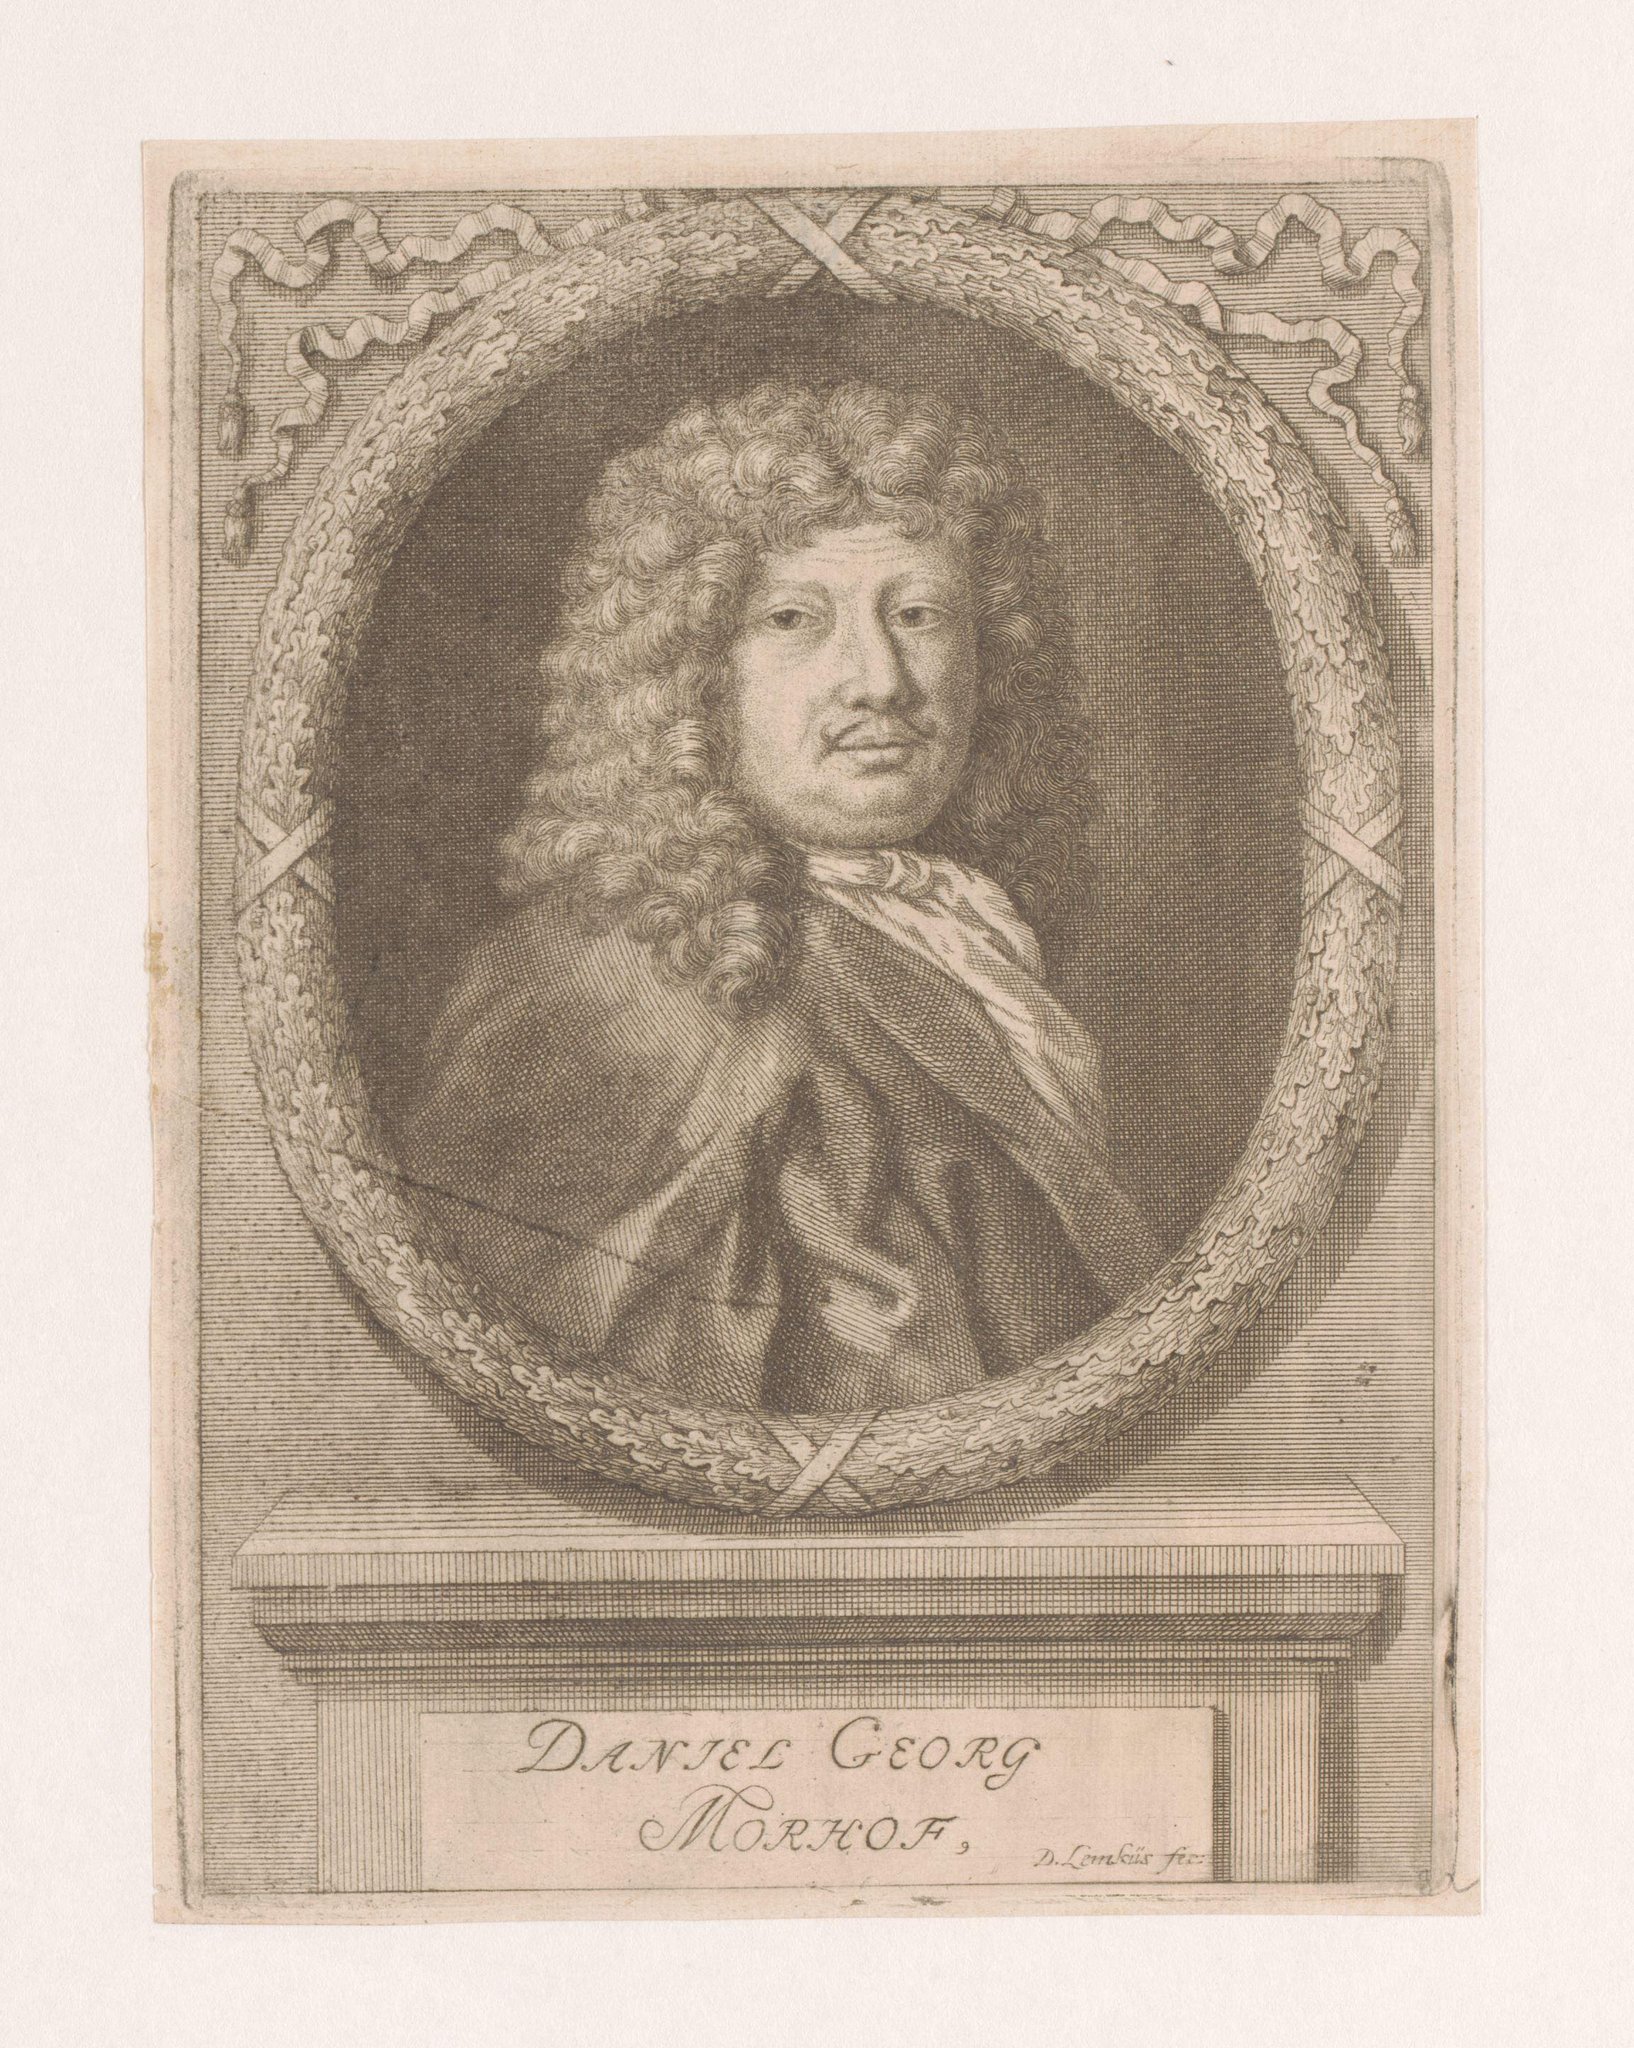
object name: print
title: Portret van Daniel Georg Morhof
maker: diederich lemkus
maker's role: print maker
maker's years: 1693-1730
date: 1702-1730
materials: paper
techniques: engraving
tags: daniel georg morhof, philology (+ portrait of scholar, scientist), historical persons, lawyer, attorney at law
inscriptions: collector's mark: Lugt 2228